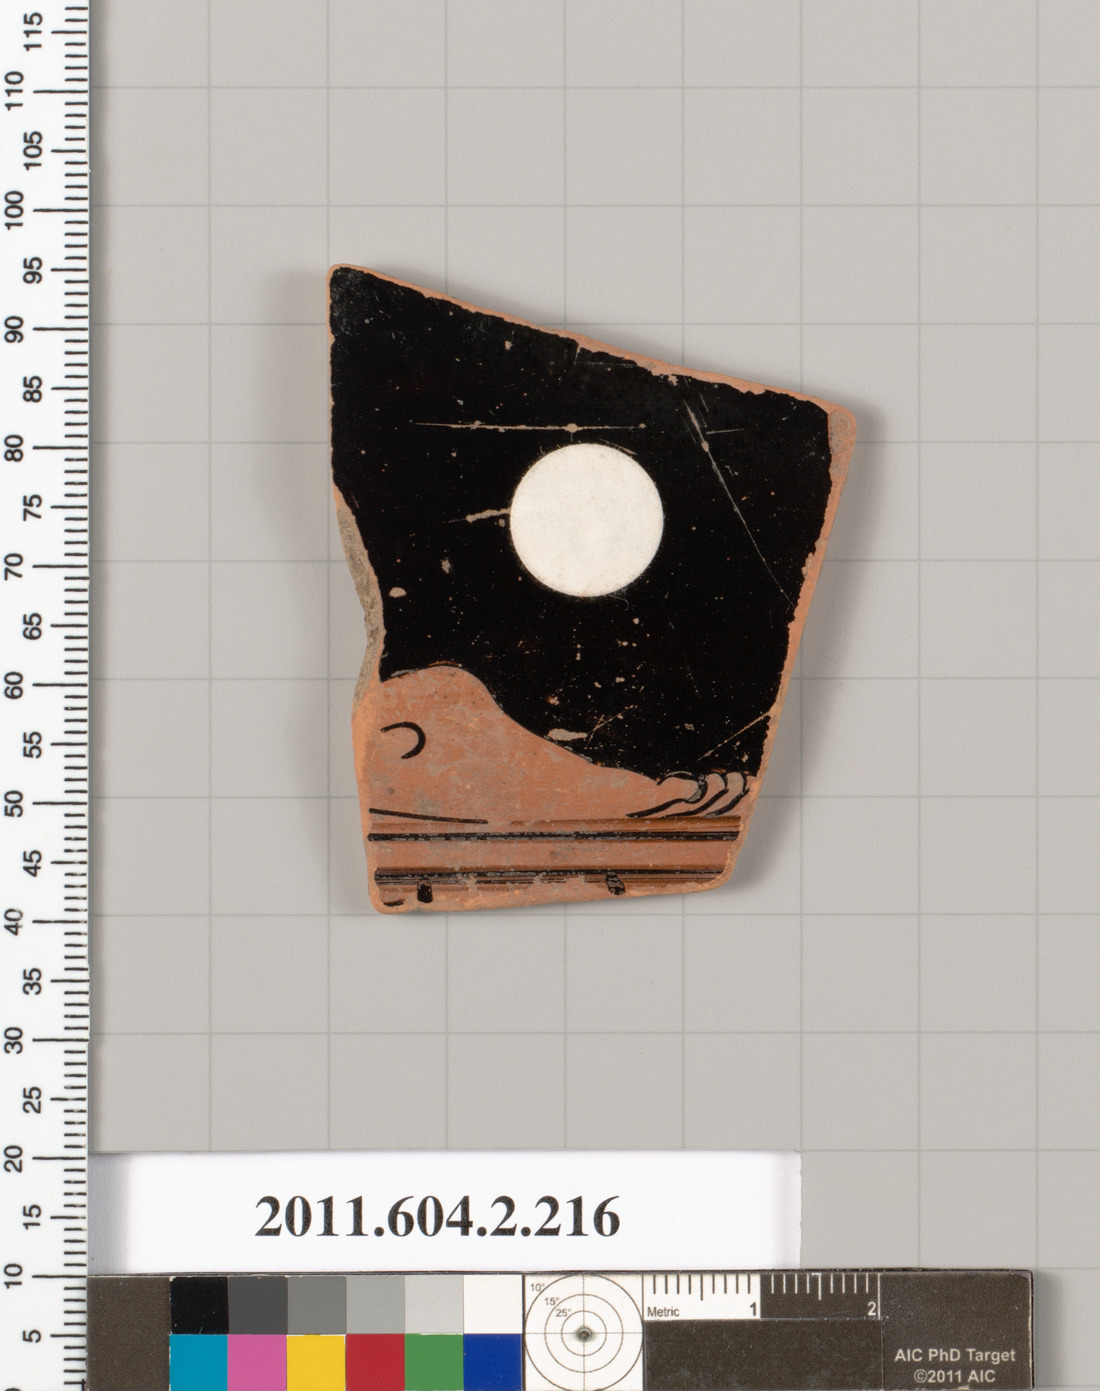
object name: stamnos fragment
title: Terracotta fragment of a stamnos (jar)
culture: greek, attic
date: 450-440 BCE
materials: terracotta